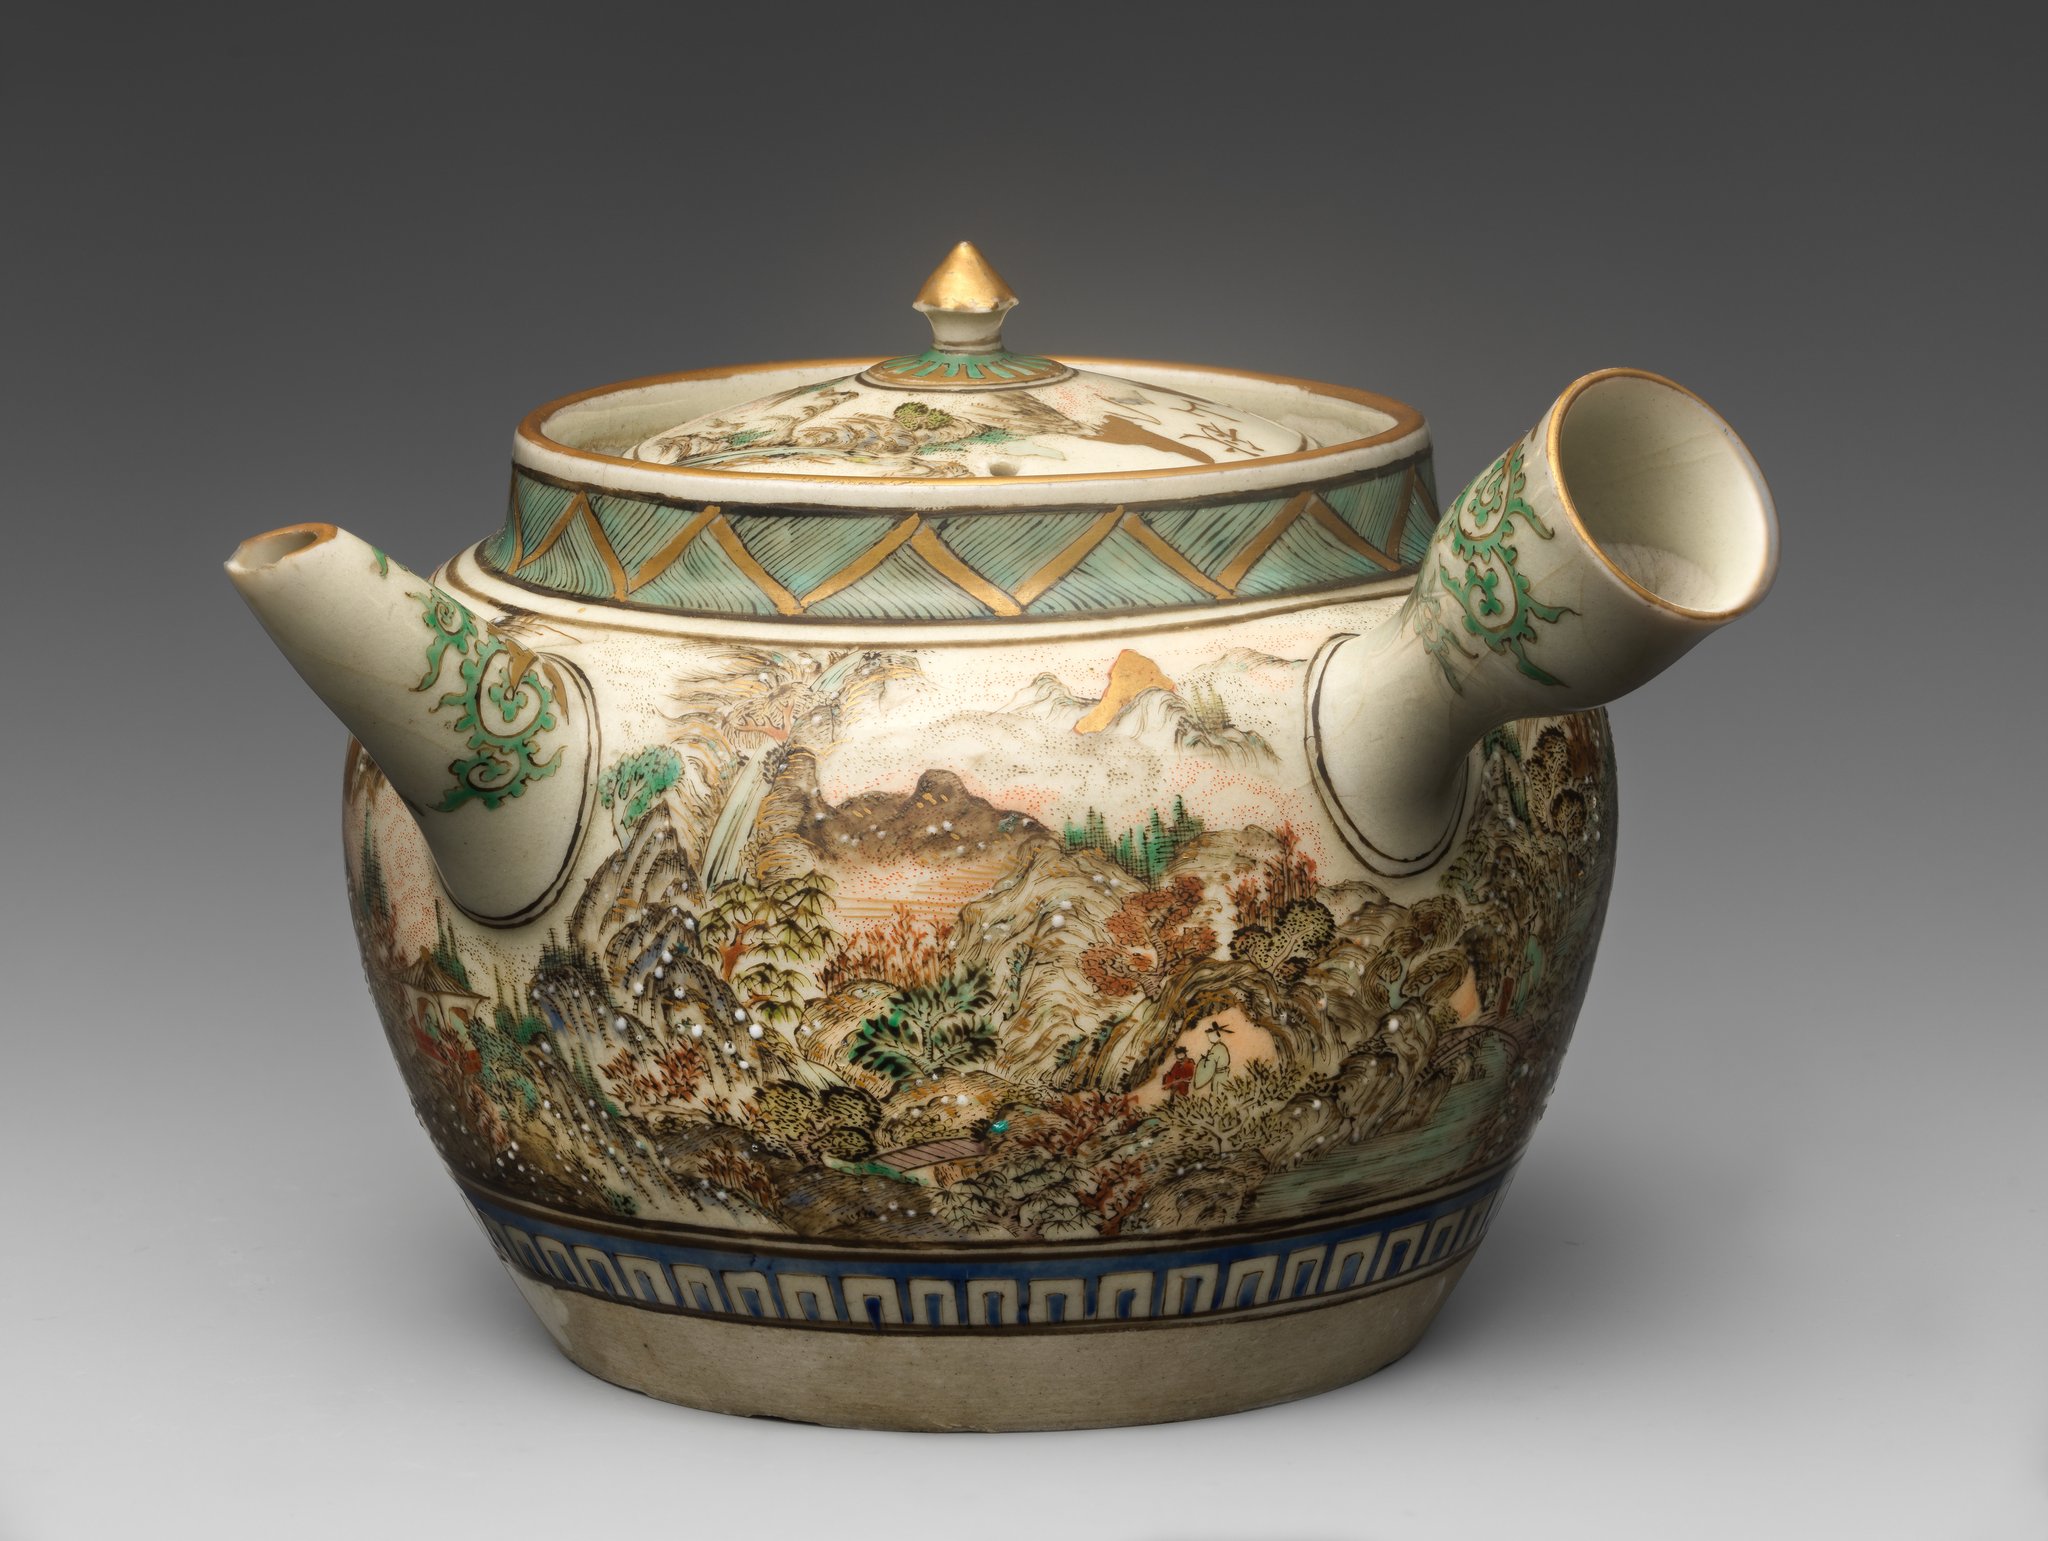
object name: teapot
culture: japanese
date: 1850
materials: glaze, pottery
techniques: enamel